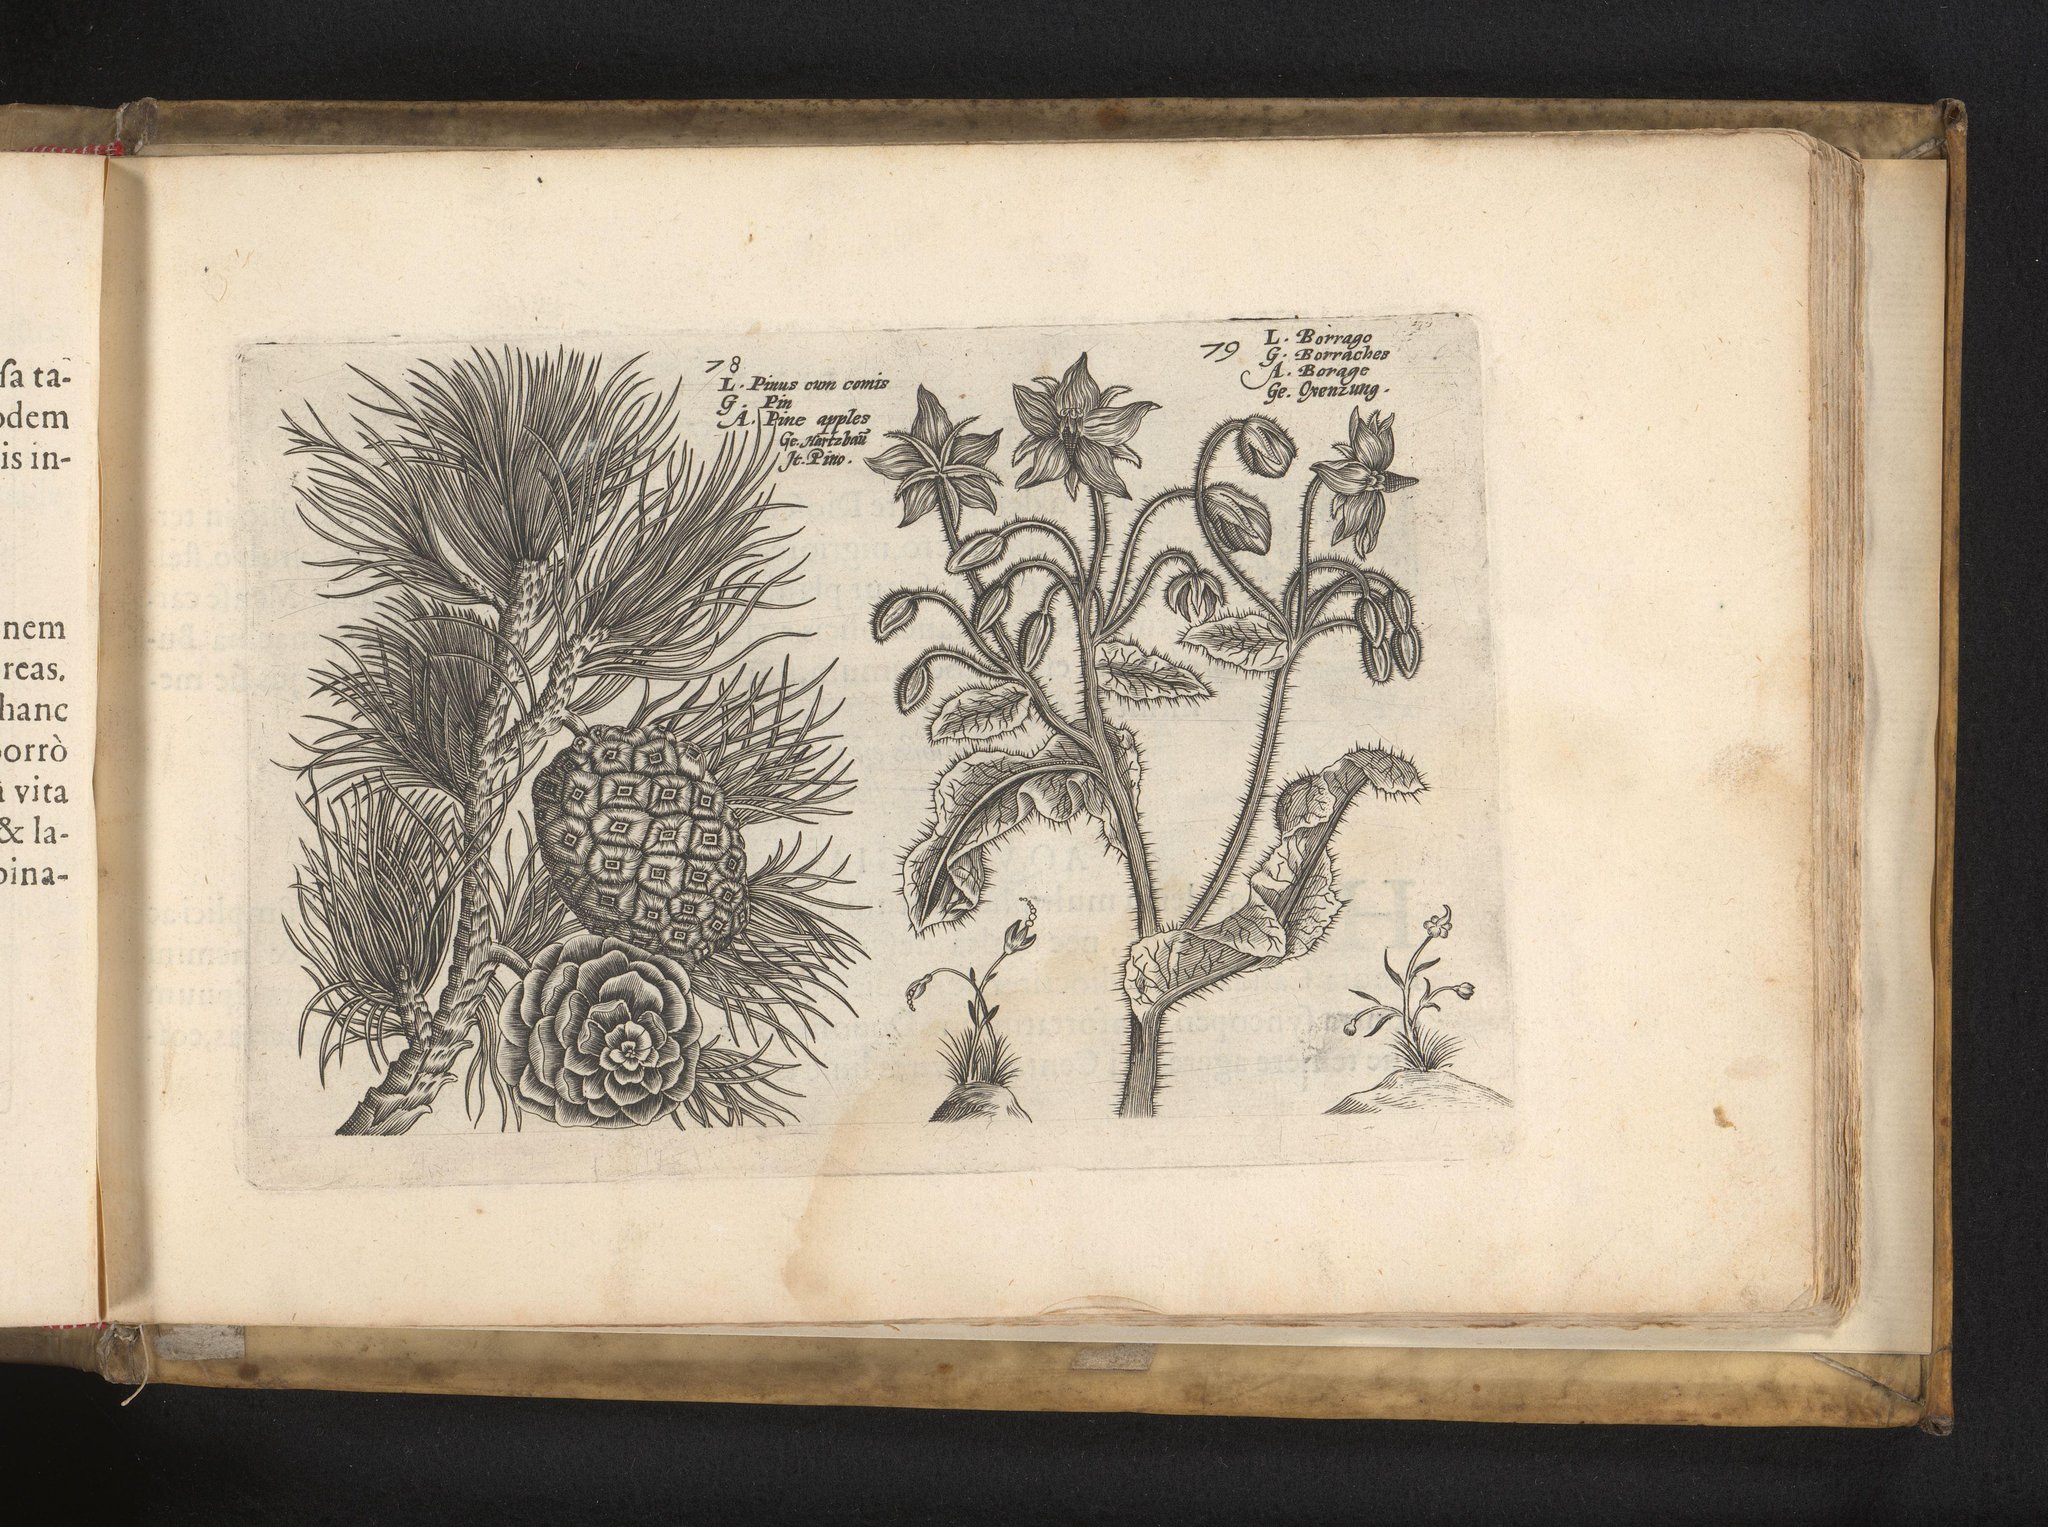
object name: book illustration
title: Bloementuin, het andere deel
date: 1617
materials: paper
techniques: engraving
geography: arnhem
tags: flowers, fruits: pine-cone, trees: pine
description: Prent uit: Passe, Crispijn van de (II). Hortus floridus in quo rariorum & minus vulgarium florum icones ad vivam veramque formam. Arnhem: Johannes Janssonius, 1617.